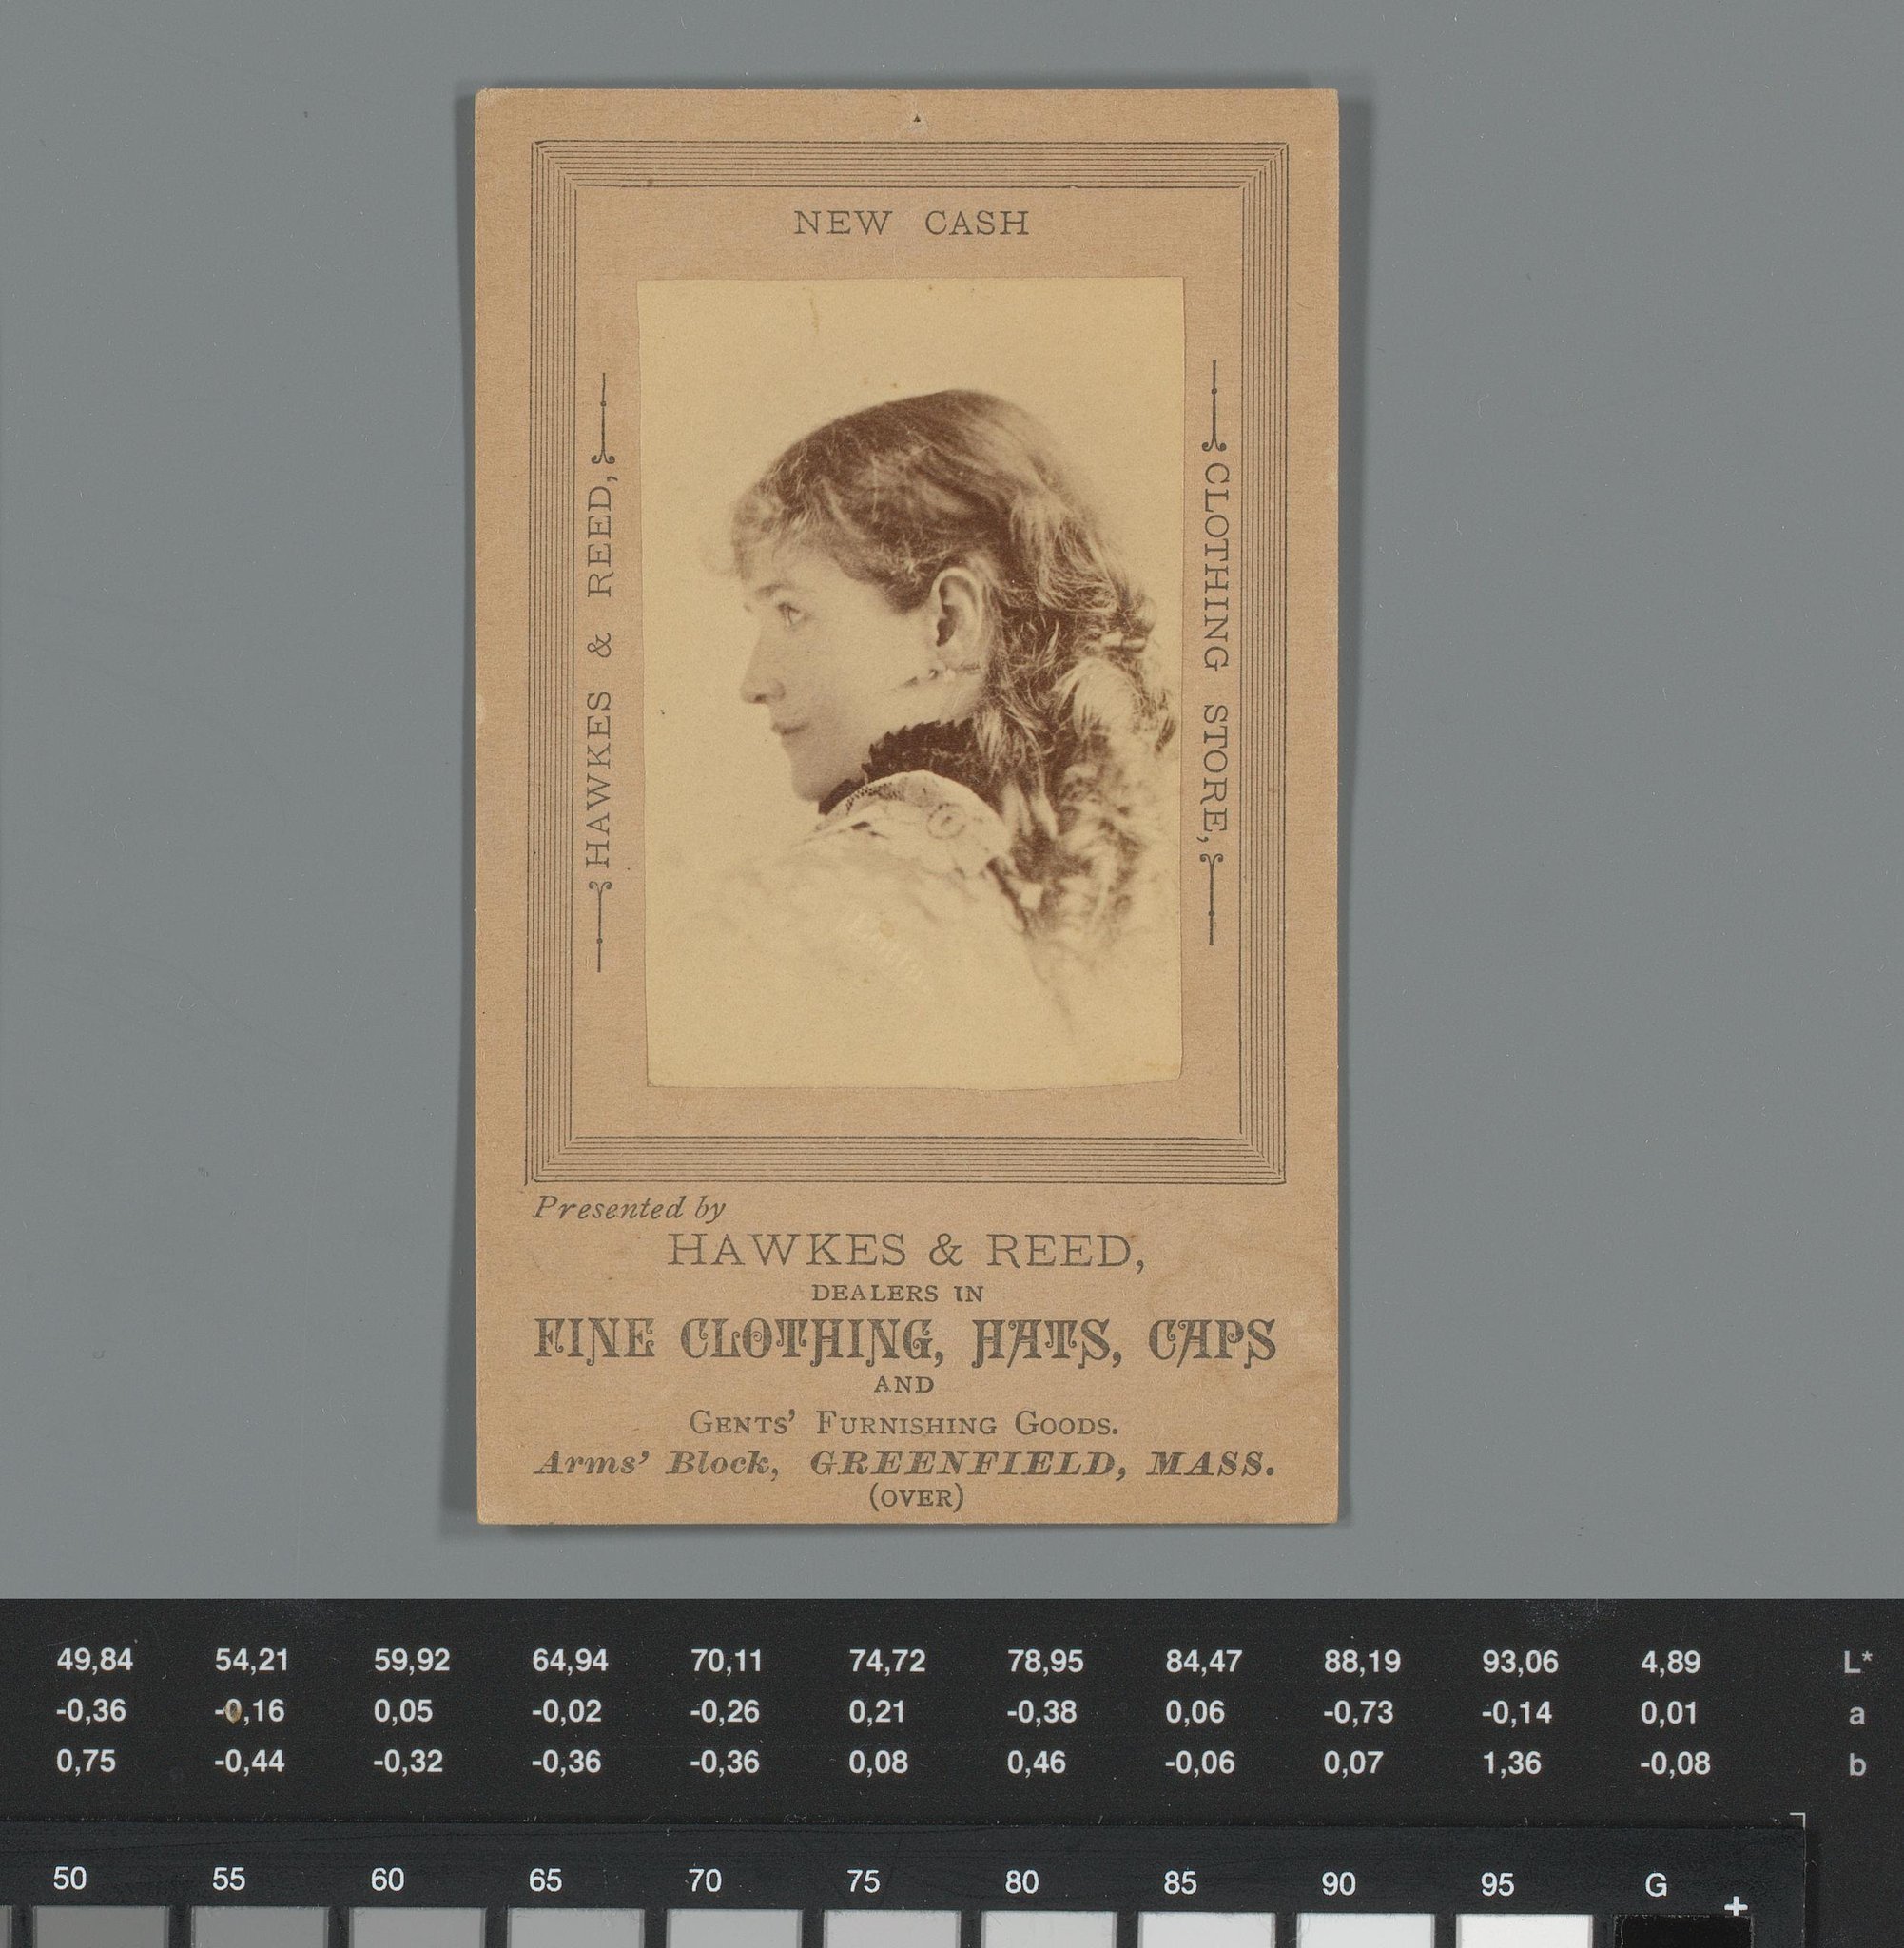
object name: carte de visite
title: Reclame voor kleding van Hwakes & Reed in Greenfield, Massachusetts, met portret van een onbekende vrouw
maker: Anonymous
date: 1850-1915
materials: cardboard, photographic support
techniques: albumen print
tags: advertising, historical persons not known by name - bb - woman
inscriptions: inscription: ‘(...)’